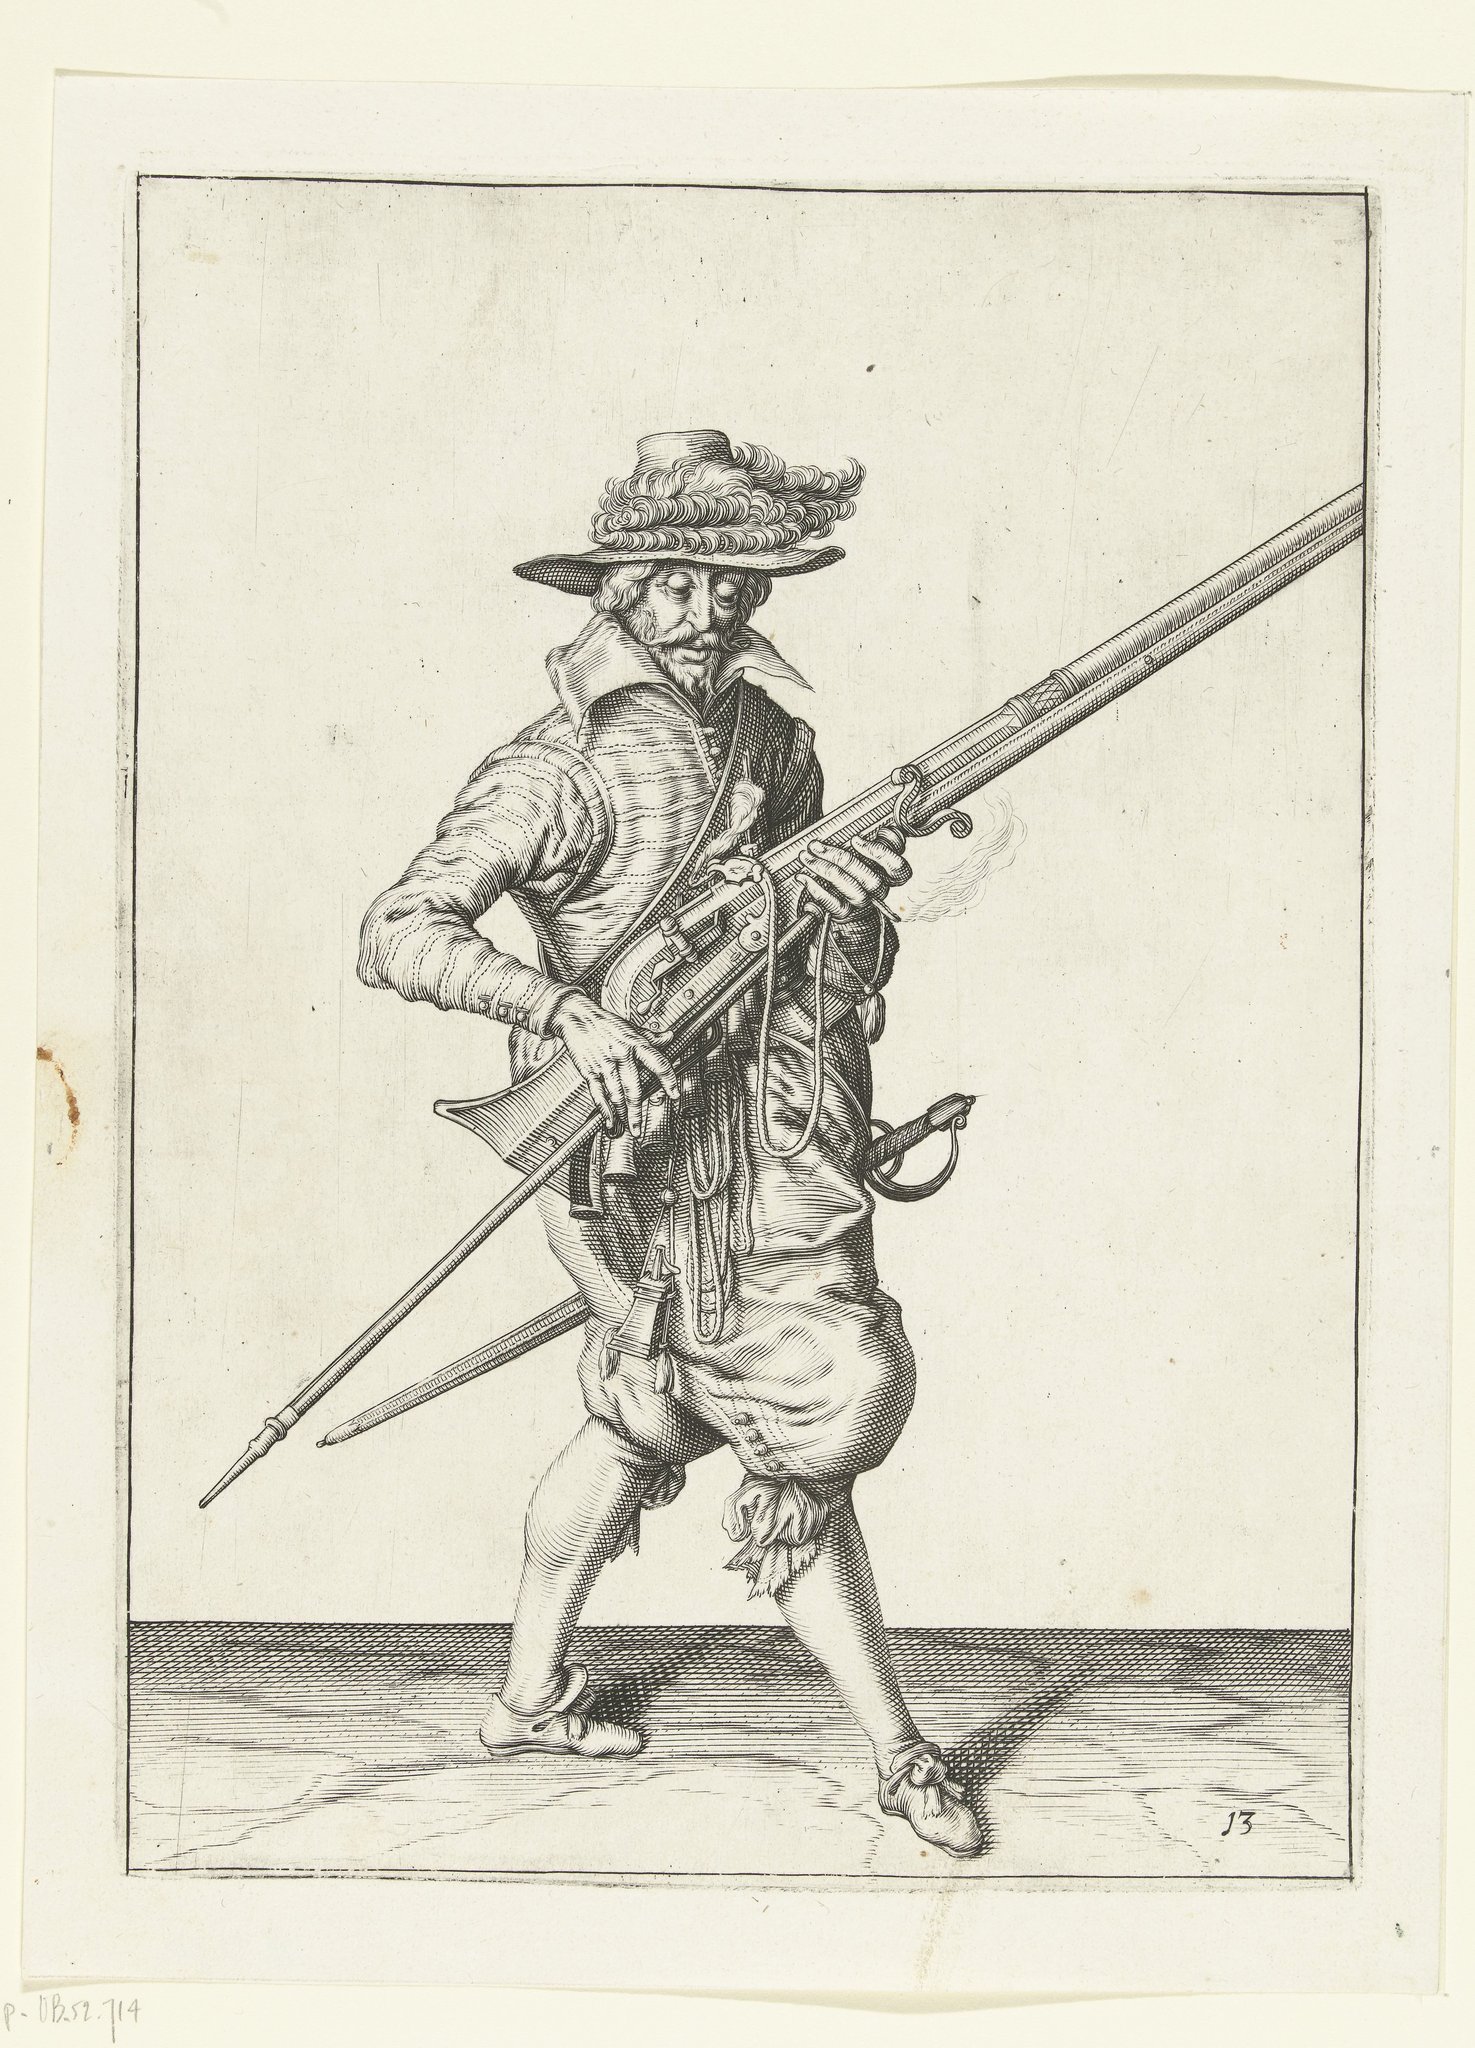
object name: print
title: Soldaat die zijn musket met zijn linkerhand schuin omhoog gericht vasthoudt, terwijl hij zijn furket onder de loop vandaan trekt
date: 1597-1607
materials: paper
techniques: engraving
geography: netherlands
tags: manoeuvre ~ military training, firearms: rifle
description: Een soldaat, ten voeten uit, naar rechts, die een musket (een bepaald type vuurwapen) met zijn linkerhand vasthoudt, nadat hij gevuurd heeft, de loop schuin omhoog gericht om te voorkomen dat hij ongewild een gezel verwondt. In zijn linkerhand behalve het roer ook een brandende lont. Met zijn rechterhand trekt hij het furket (de musketvork) onder de loop vandaan. Deze prent is onderdeel van de reeks van 43 genummerde prenten van musketiers uit de Wapenhandelinghe.